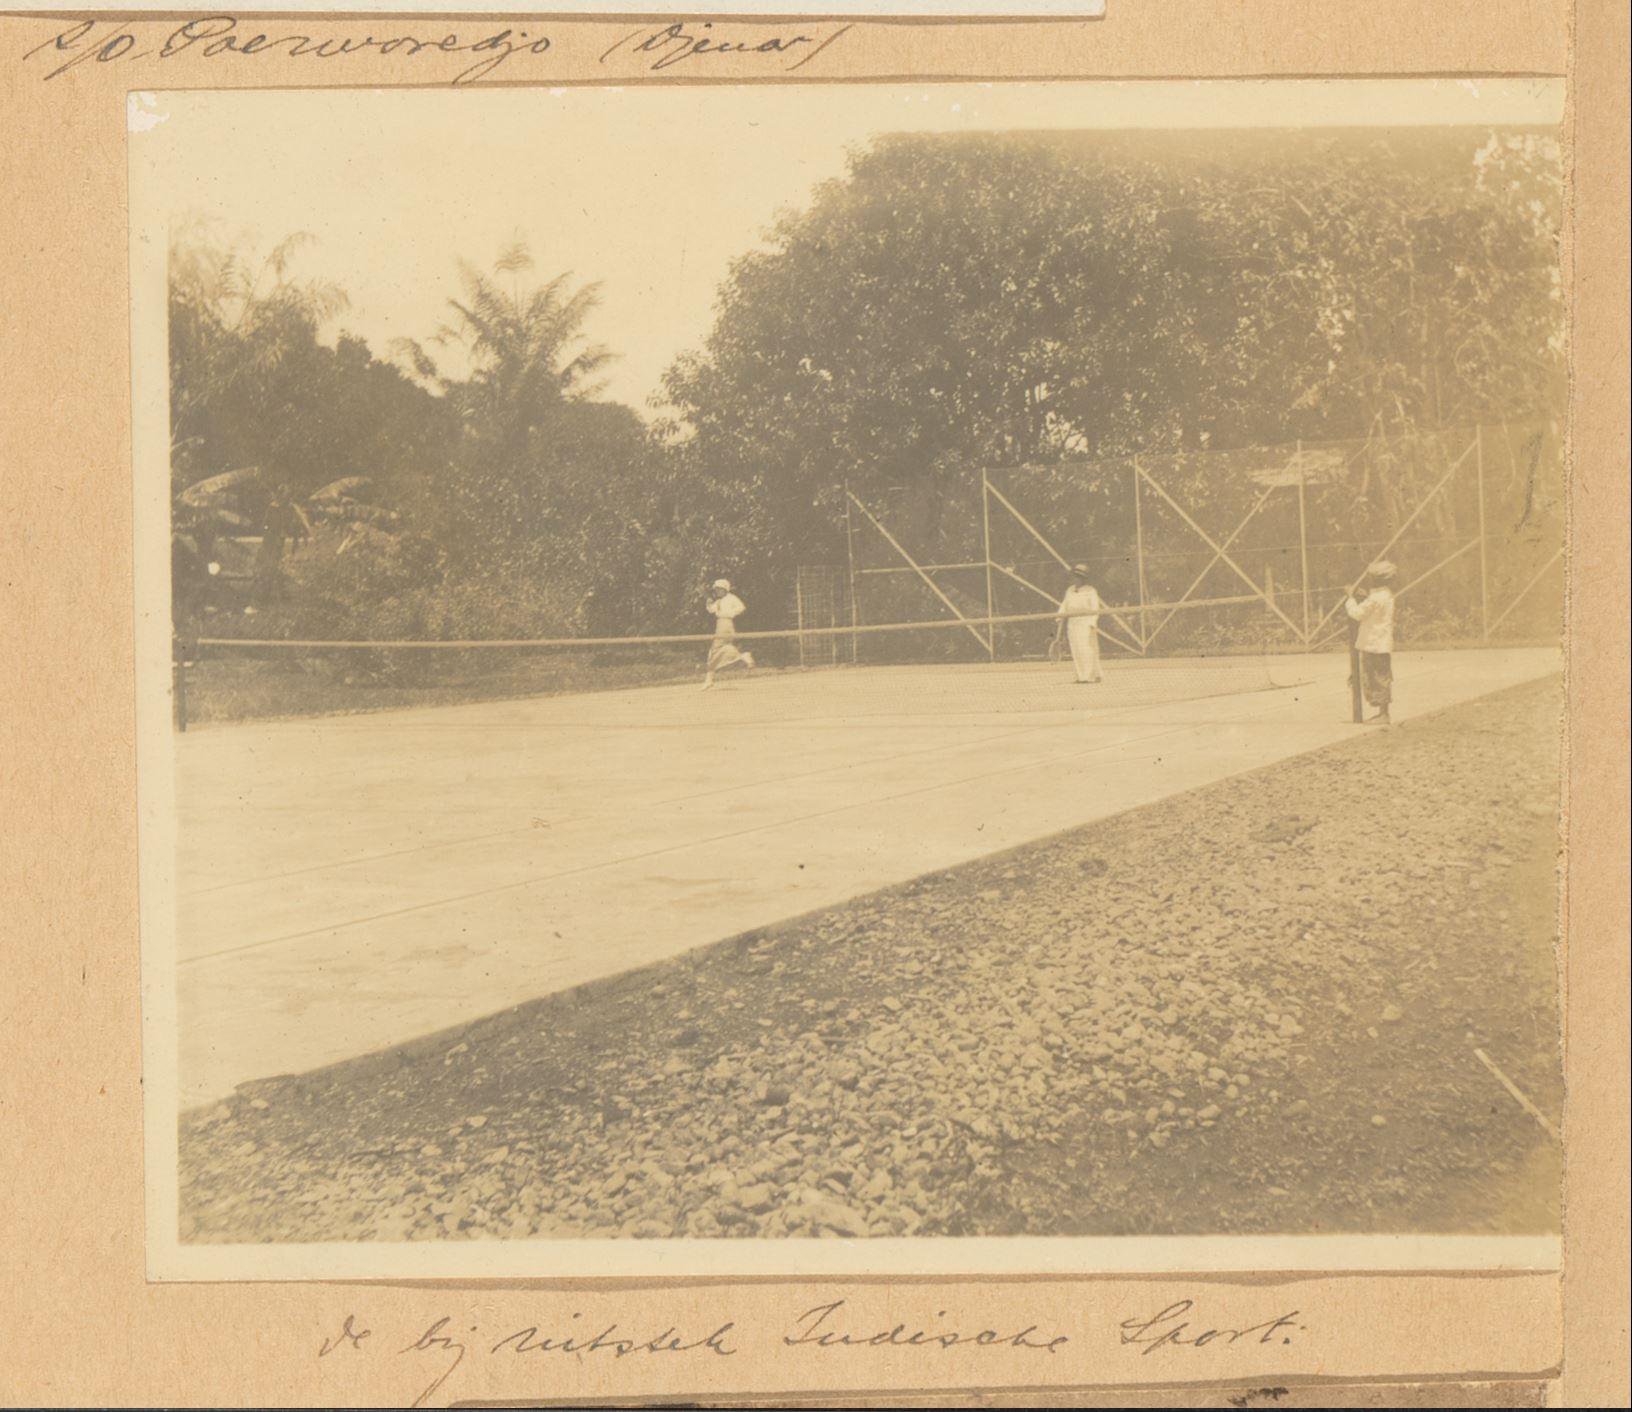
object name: photograph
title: Europese vrouwen tijdens tennisspel in Nederlands-Indië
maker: Anonymous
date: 1917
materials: photographic support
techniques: daylight paper print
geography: dutch east indies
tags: tennis, lawn-tennis (+ sportsman, player, etc.), dutch east indies, the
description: Onderdeel van Familiealbum met foto's van een familie in de voormalige kolonie Nederlands-Indië en van een suikerfabriek in Purworejo.